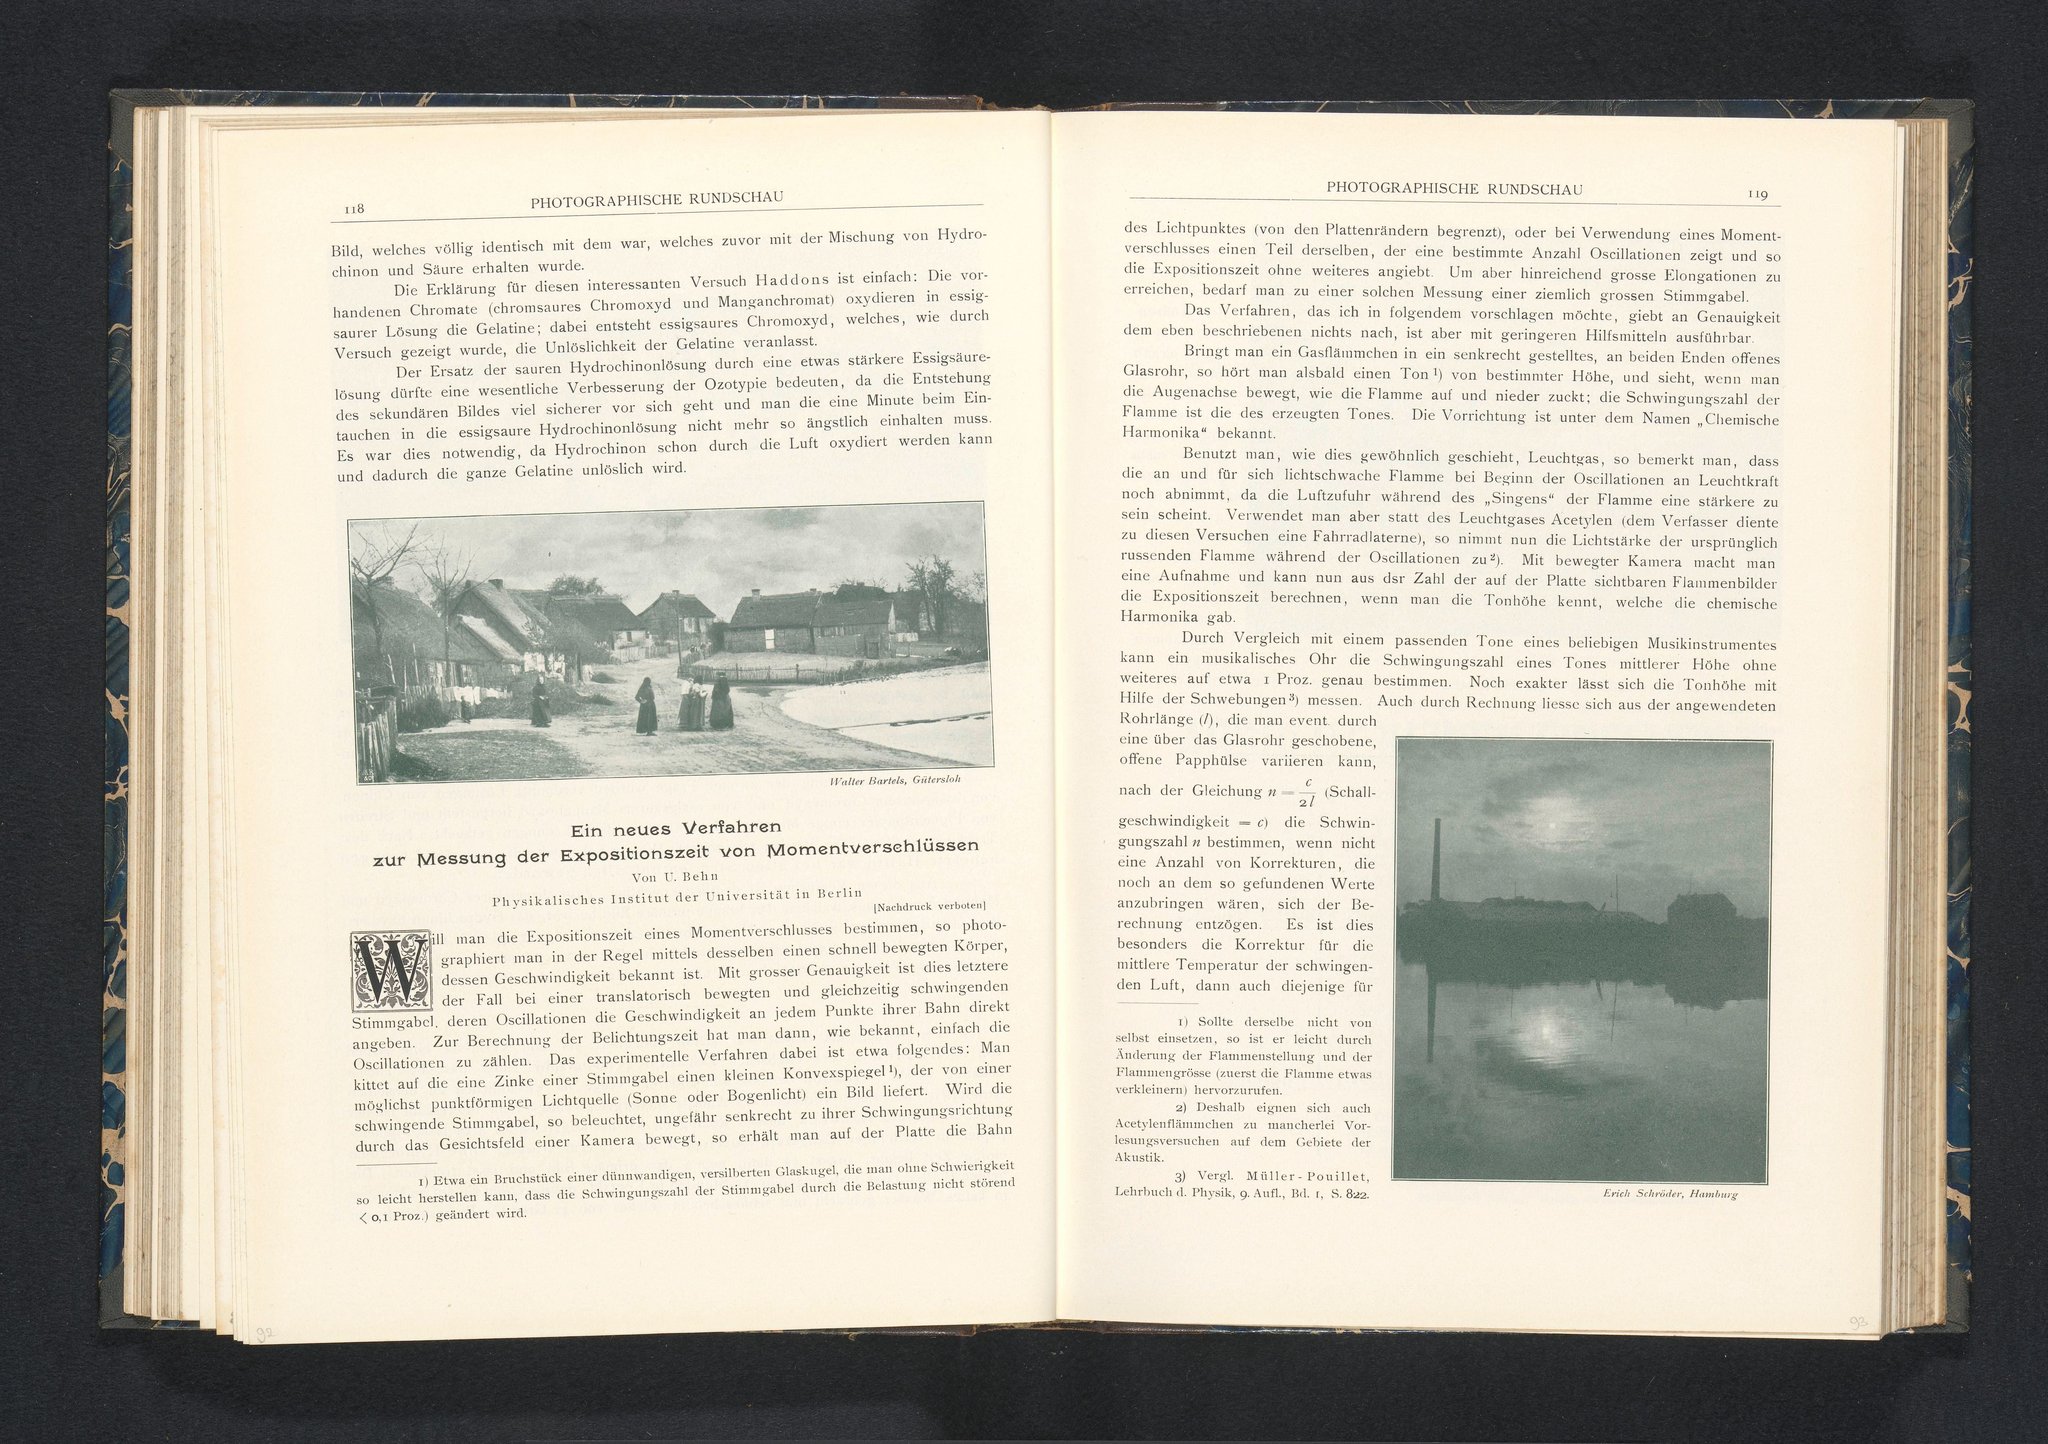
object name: page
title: Gezicht op een fabrieksgebouw, met op de voorgrond een waterweg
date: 1896-1901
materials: paper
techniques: autotype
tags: factory-building, river